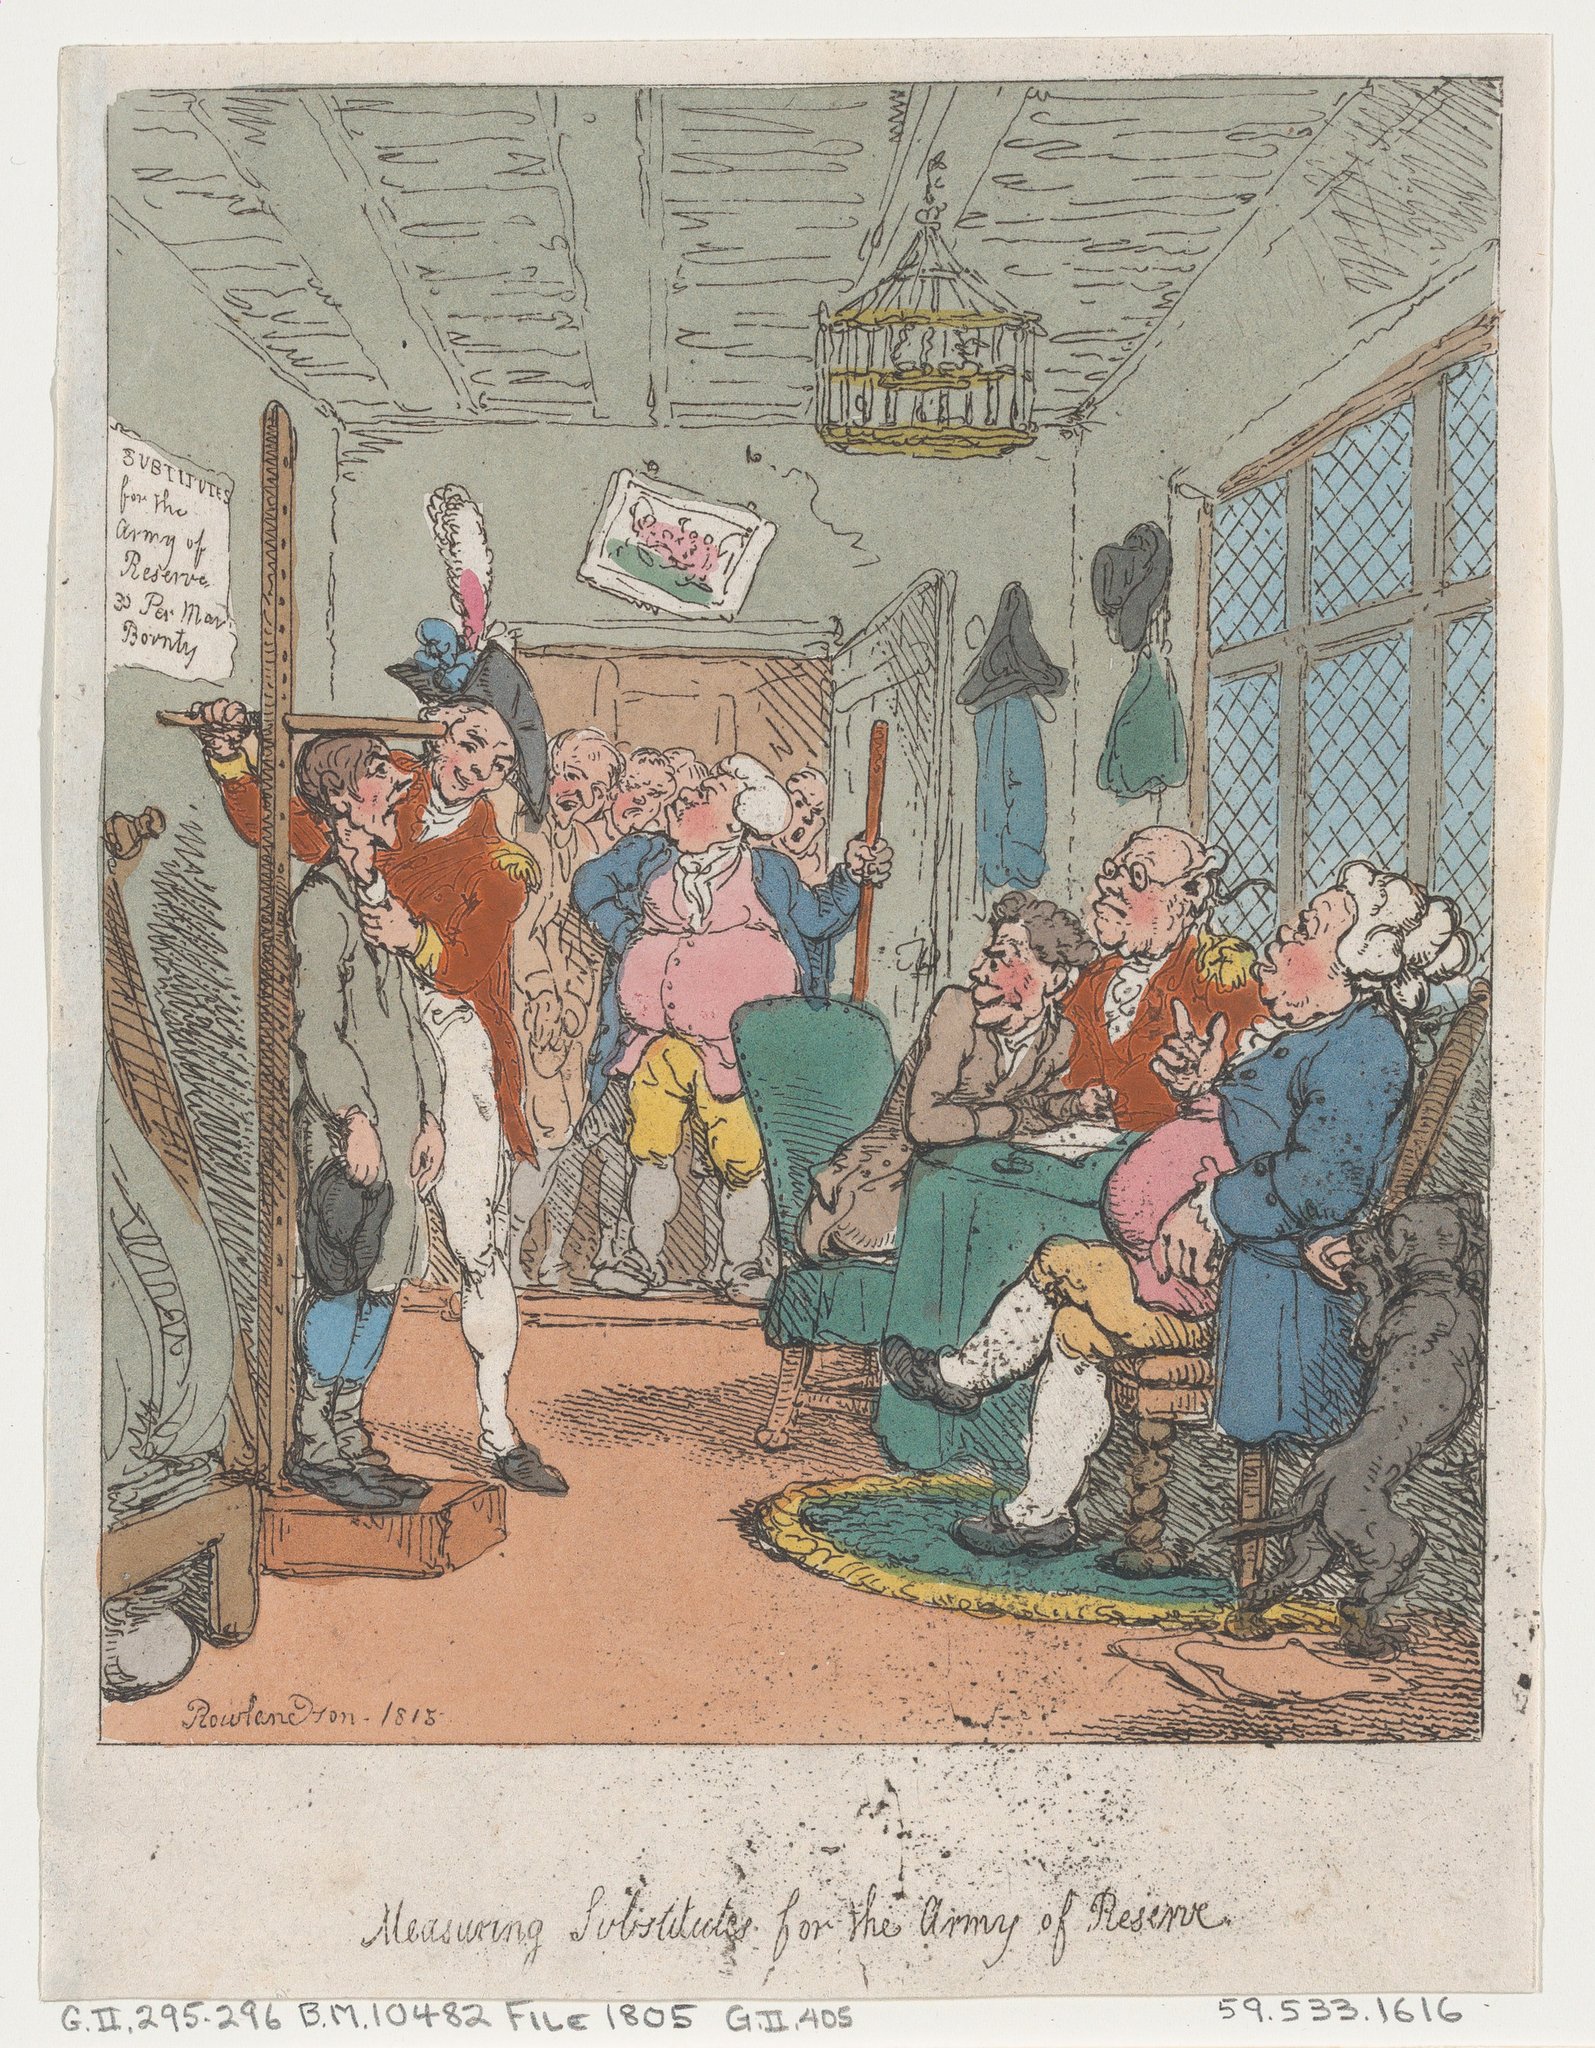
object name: print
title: Measuring Substitutes for the Army of Reserve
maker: thomas rowlandson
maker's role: artist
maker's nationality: british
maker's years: 1757-1827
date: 1815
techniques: etching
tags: men